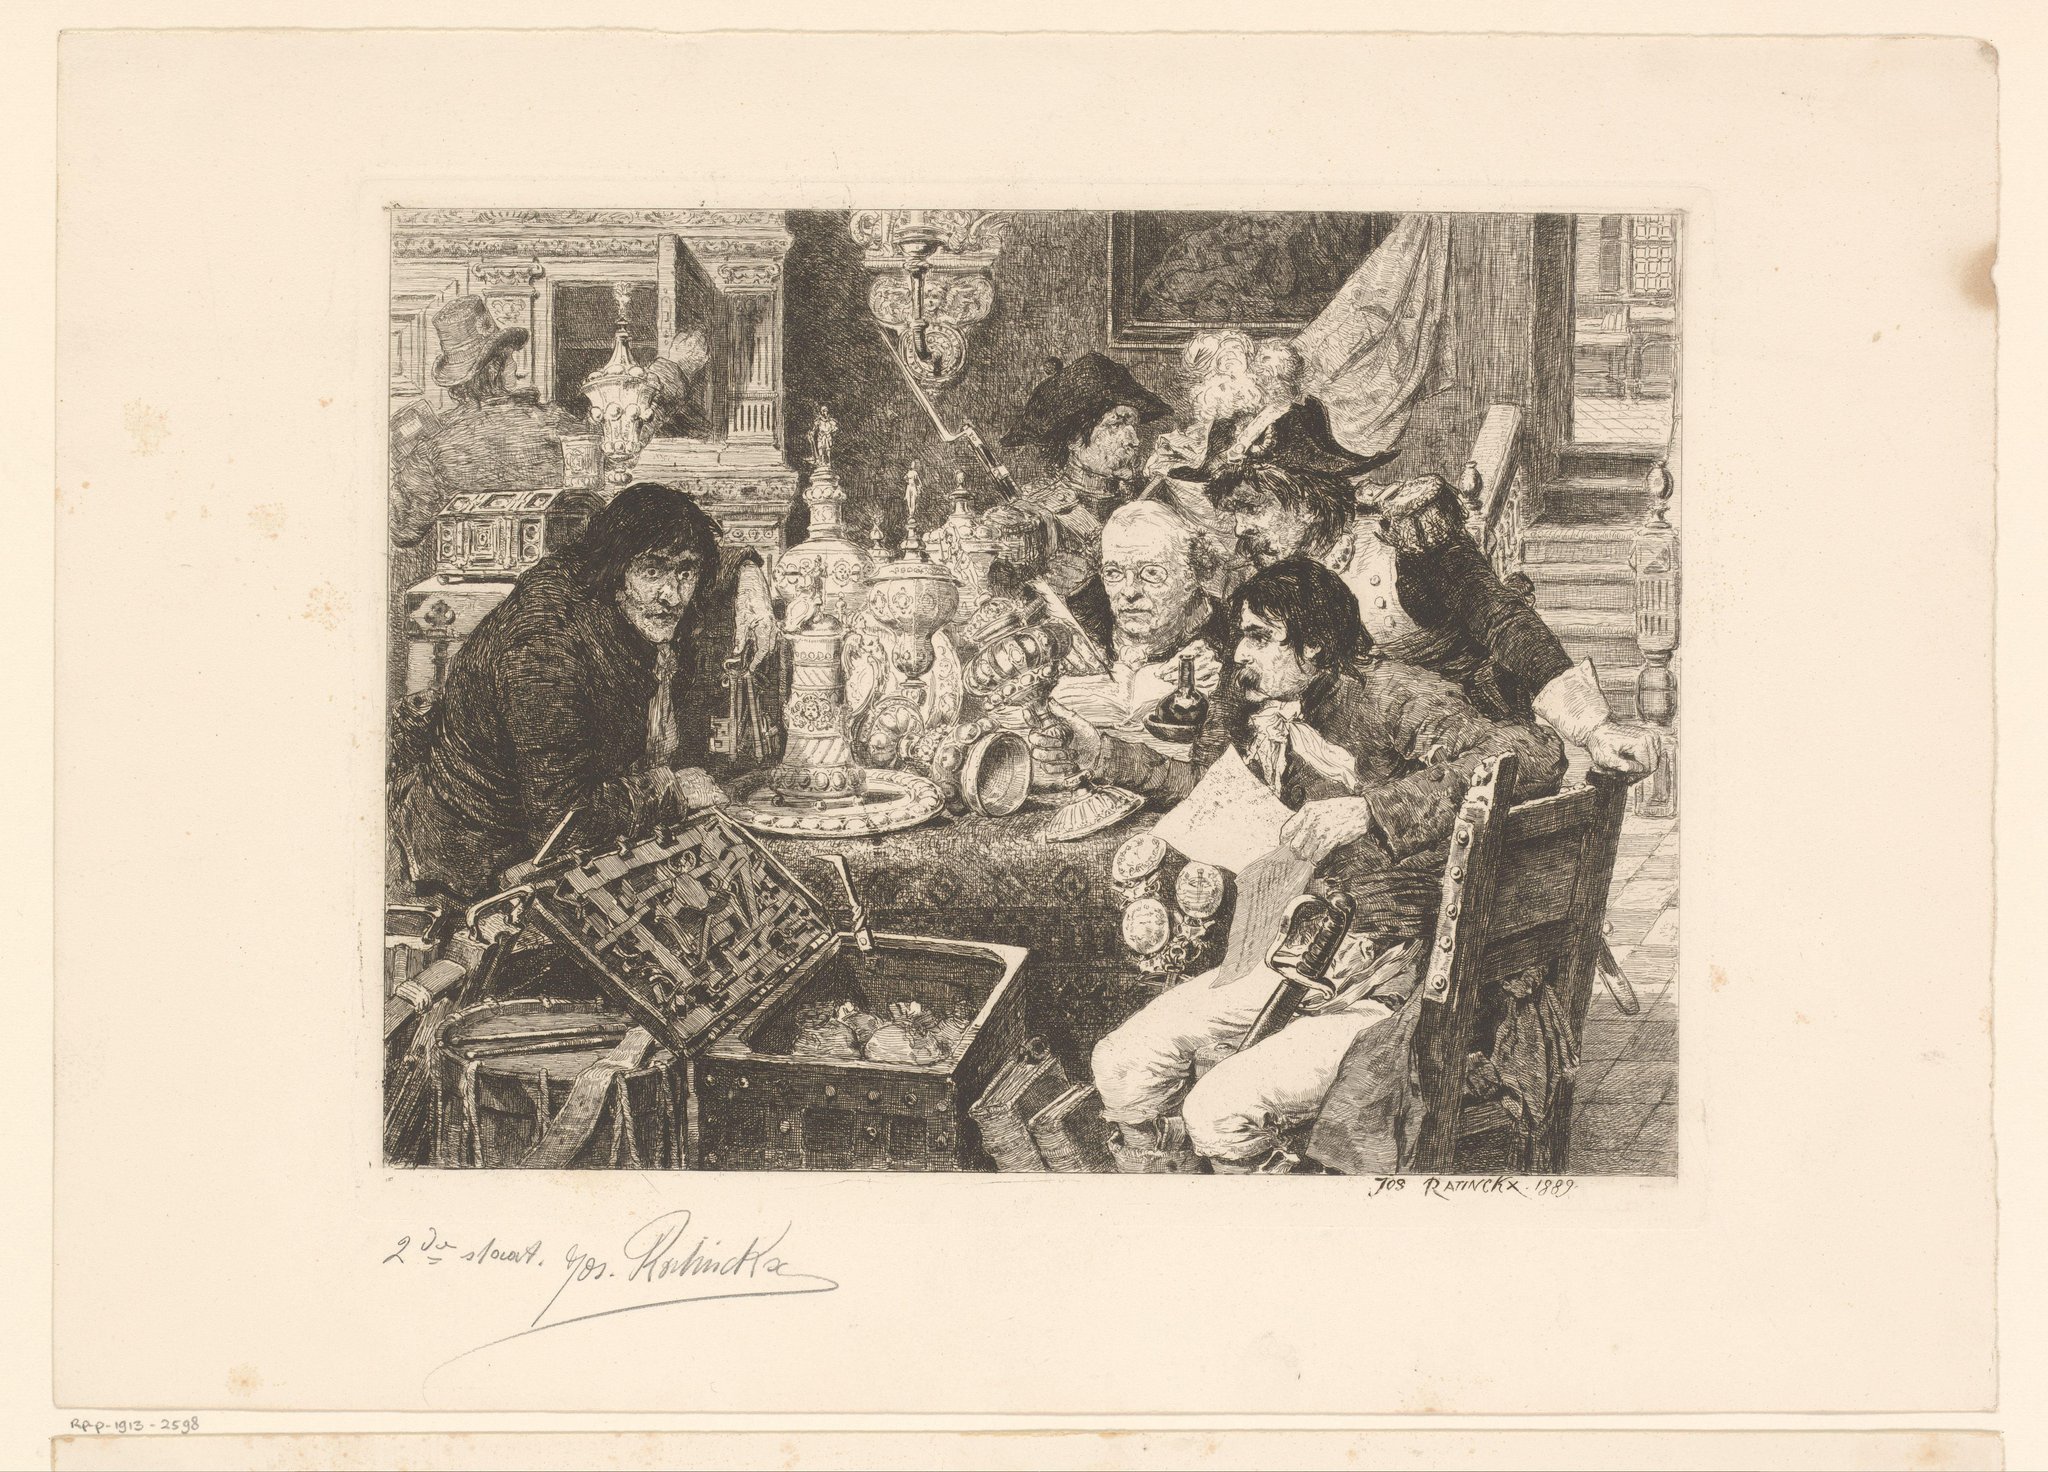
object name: print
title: Zes mannen in een interieur rondom een tafel bekijken rijkelijk vaatwerk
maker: jos ratinckx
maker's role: print maker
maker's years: 1860-1937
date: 1889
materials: paper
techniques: etching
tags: mug, beaker, goblet, interior ~ representation of a building, money-chest, treasure-chest, money-box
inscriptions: collector's mark: Lugt 2228, inscription: ‘2de staat’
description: De prent verwijst naar de vernietiging van de gildeschatten in 1794.